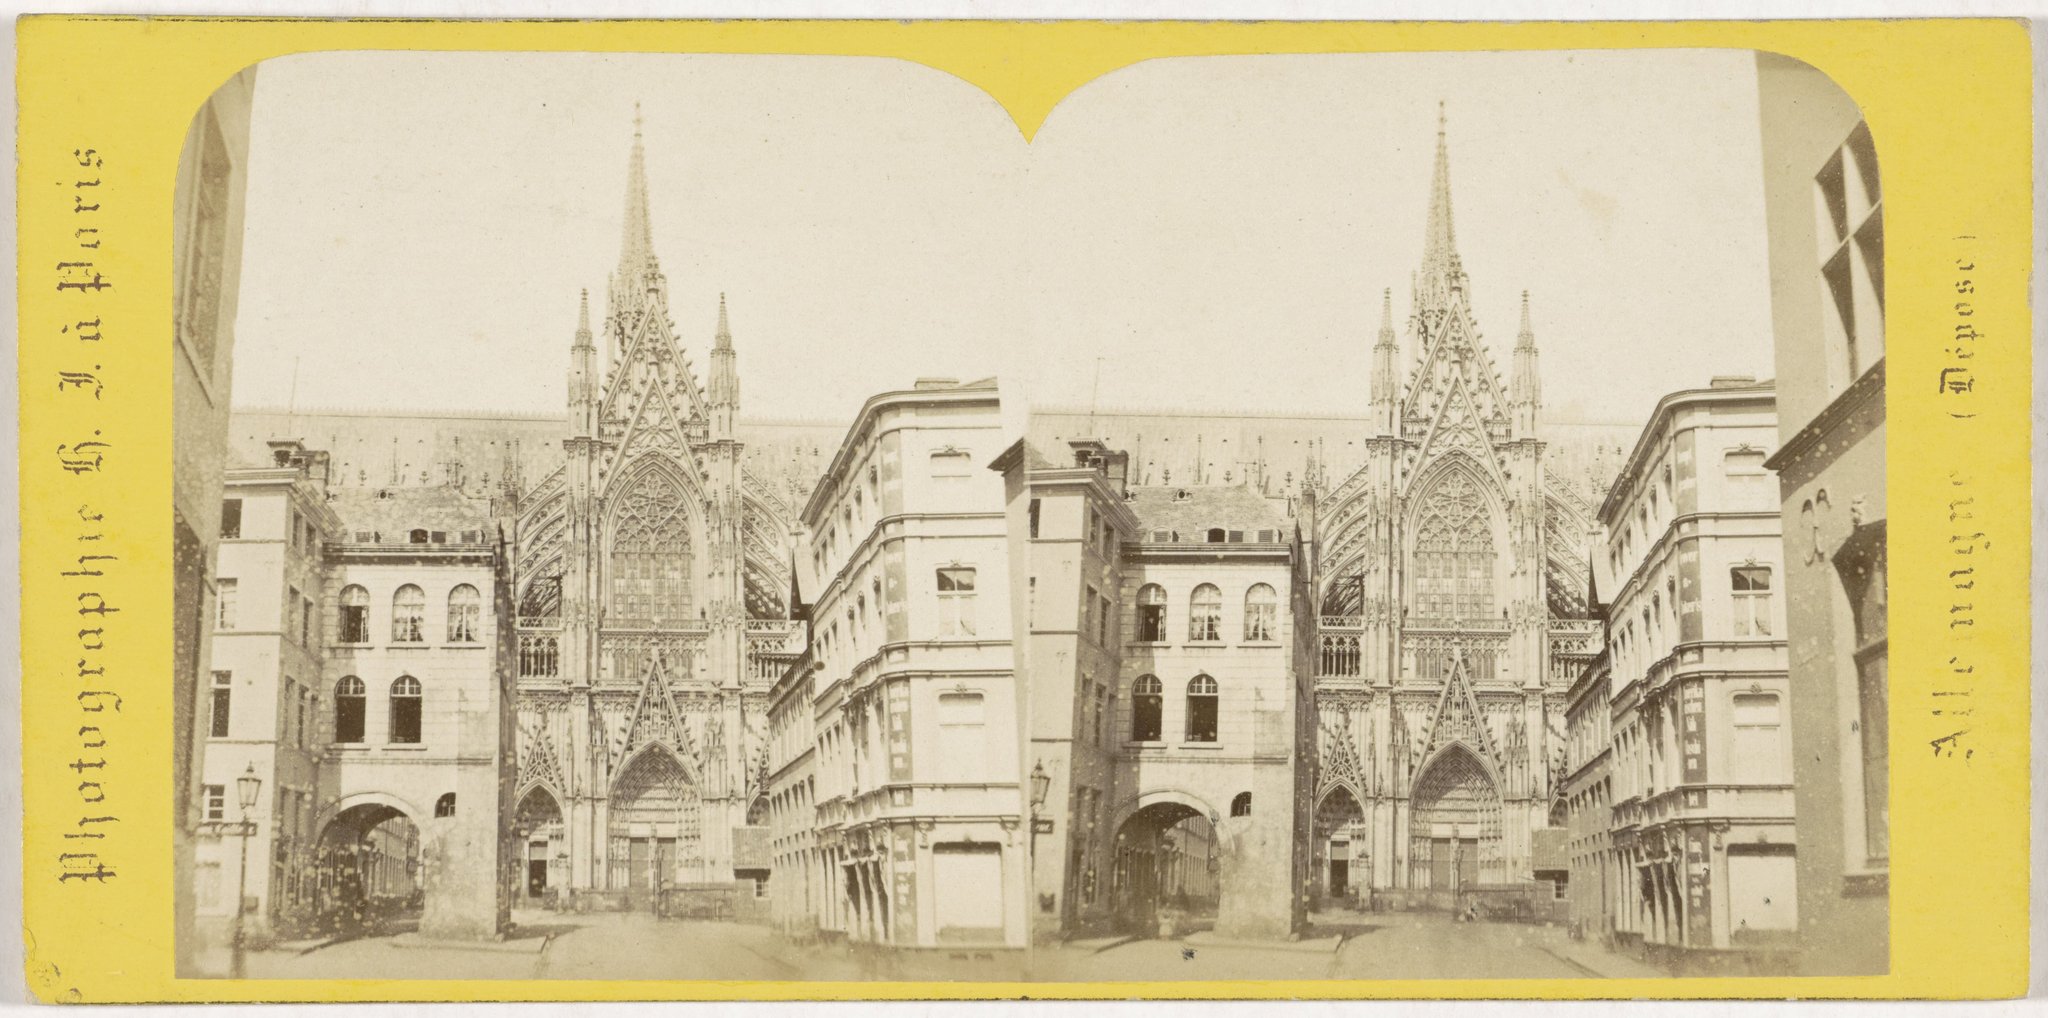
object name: stereograph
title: Zuidelijke façade van de Dom van Keulen, Duitsland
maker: hippolyte jouvin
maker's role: fotograaf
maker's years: 1825-1889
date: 1864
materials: cardboard, paper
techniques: albumen print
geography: cologne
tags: urban housing, church (exterior)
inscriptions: inscription: ‘(Déposé)’, inscription: ‘Déposé.’, number: ‘N. 552’